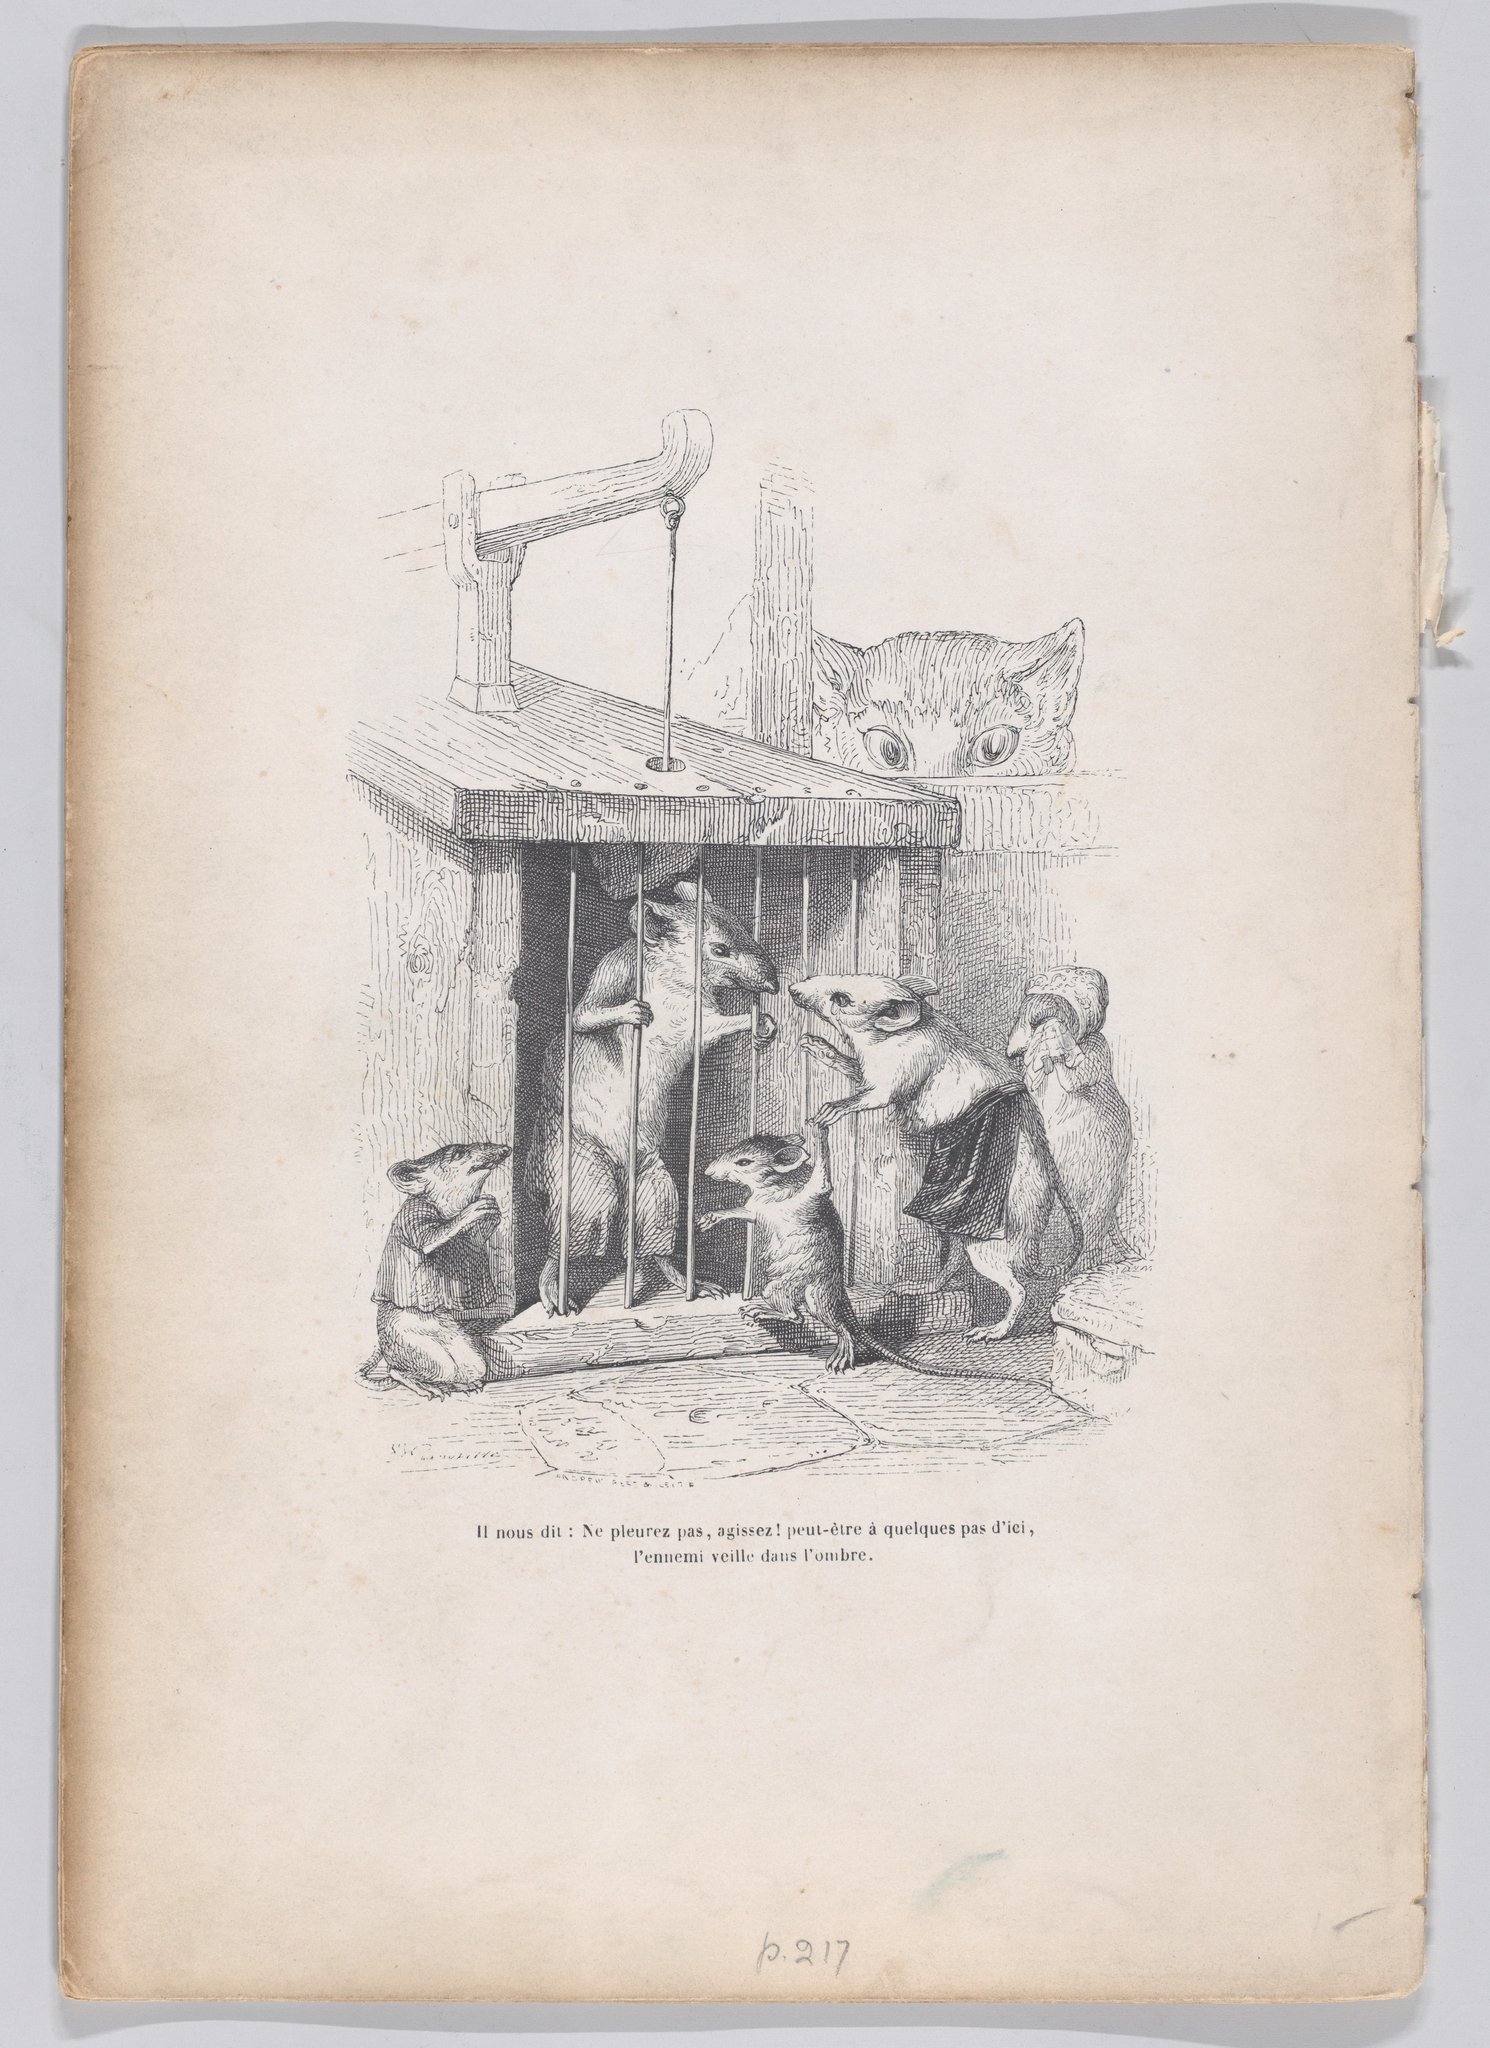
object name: print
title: He tells us: don't cry, Act!, from "Scenes from the Private and Public Life of Animals"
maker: j. j. grandville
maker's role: illustrator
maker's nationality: french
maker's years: 1803-1847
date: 1837-1847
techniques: engraving